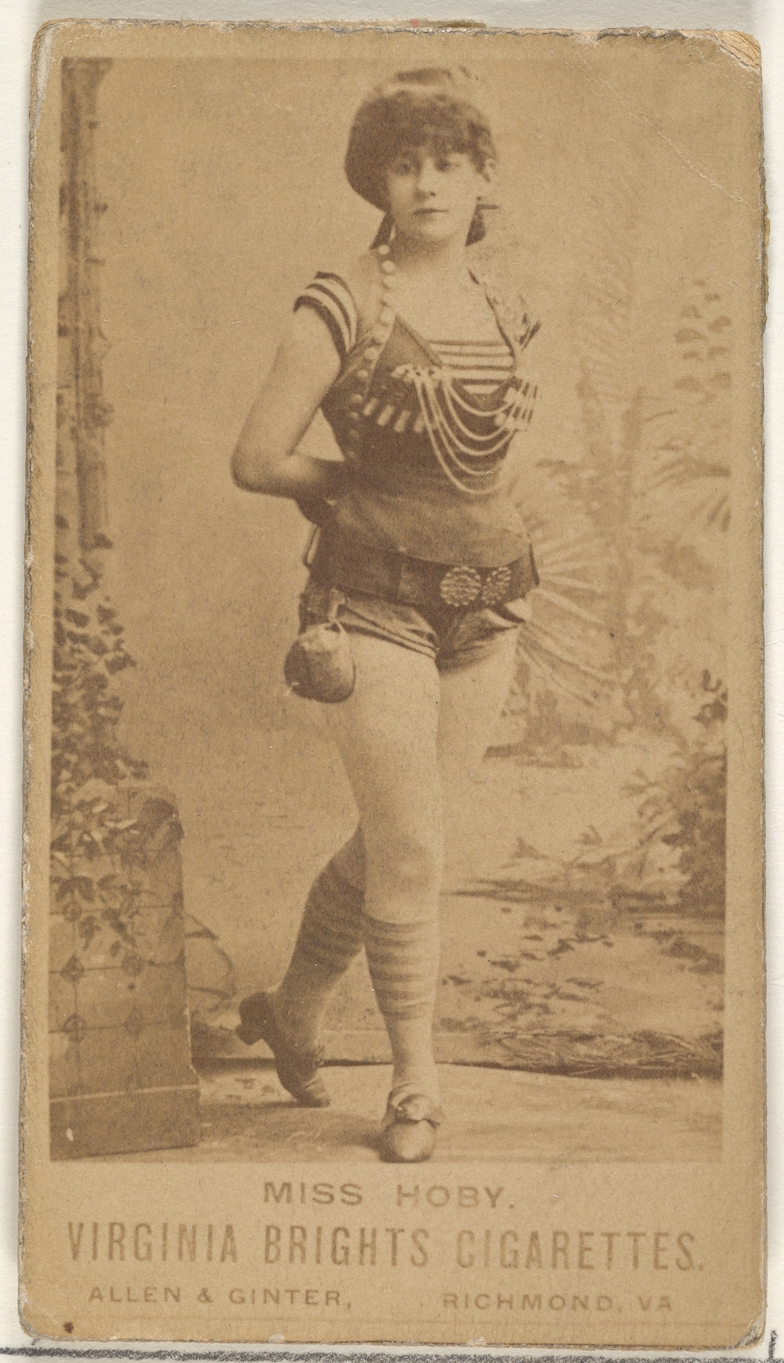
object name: photograph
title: Miss Hoby, from the Actors and Actresses series (N45, Type 1) for Virginia Brights Cigarettes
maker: allen & ginter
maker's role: publisher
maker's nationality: american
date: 1888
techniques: albumen silver print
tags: portraits,women,actresses